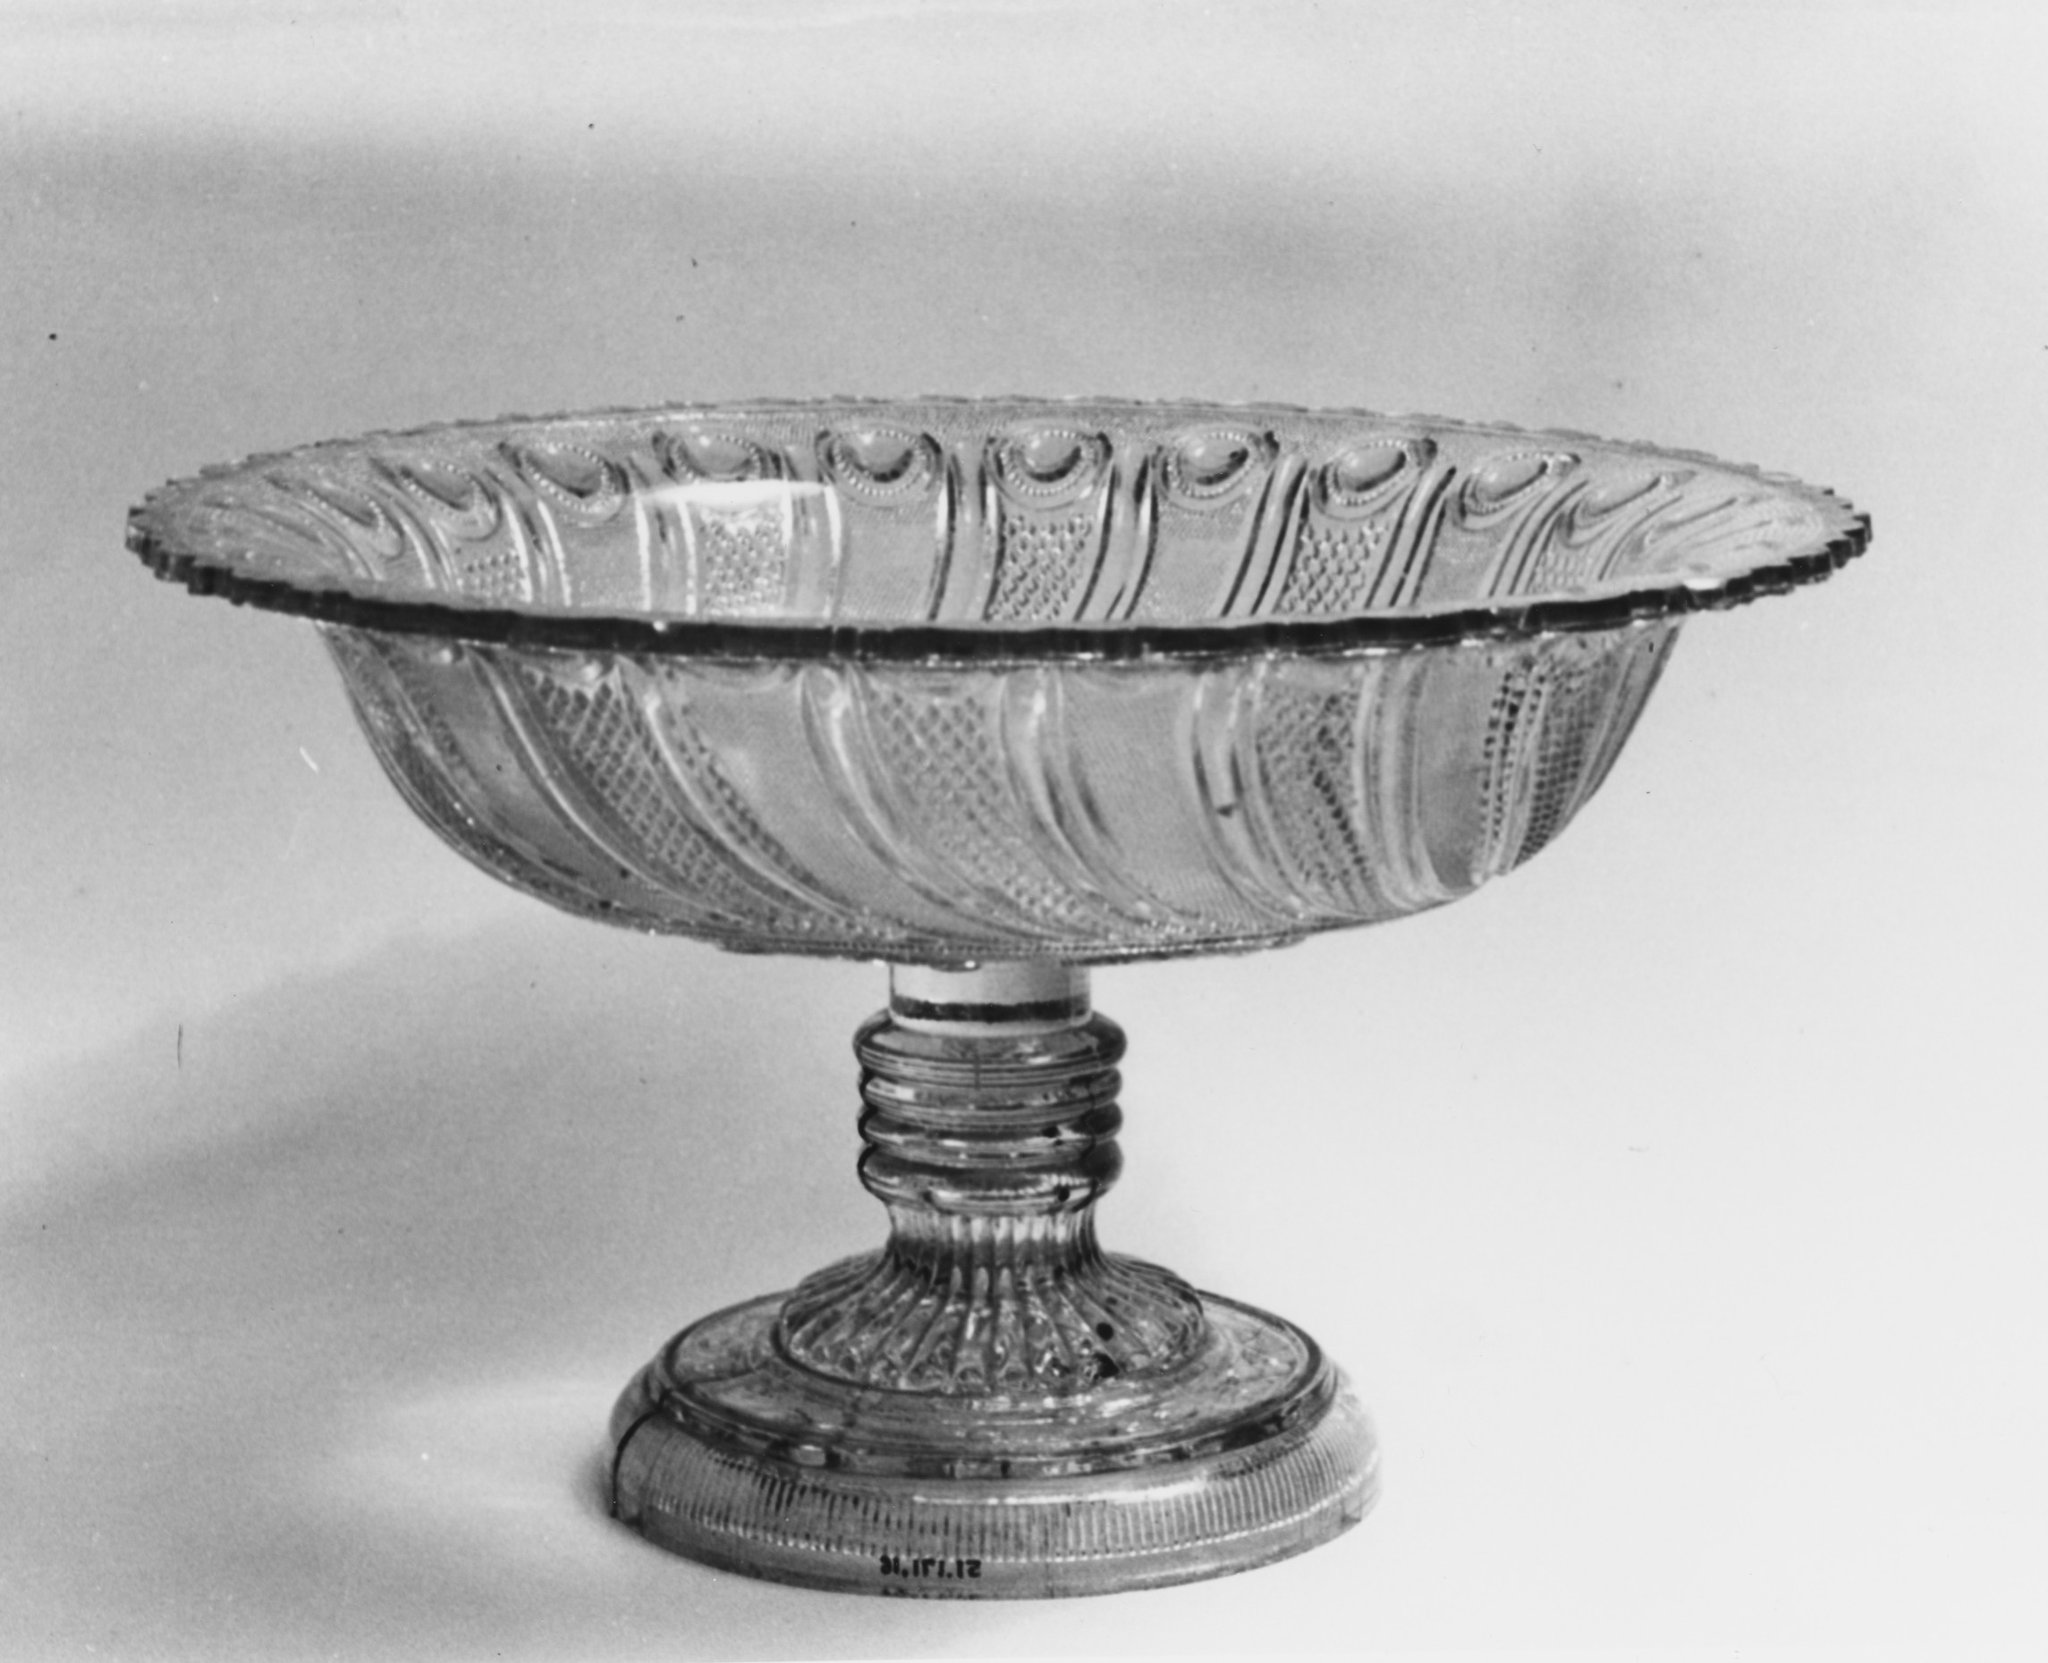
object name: compote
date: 1801-1900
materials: glass